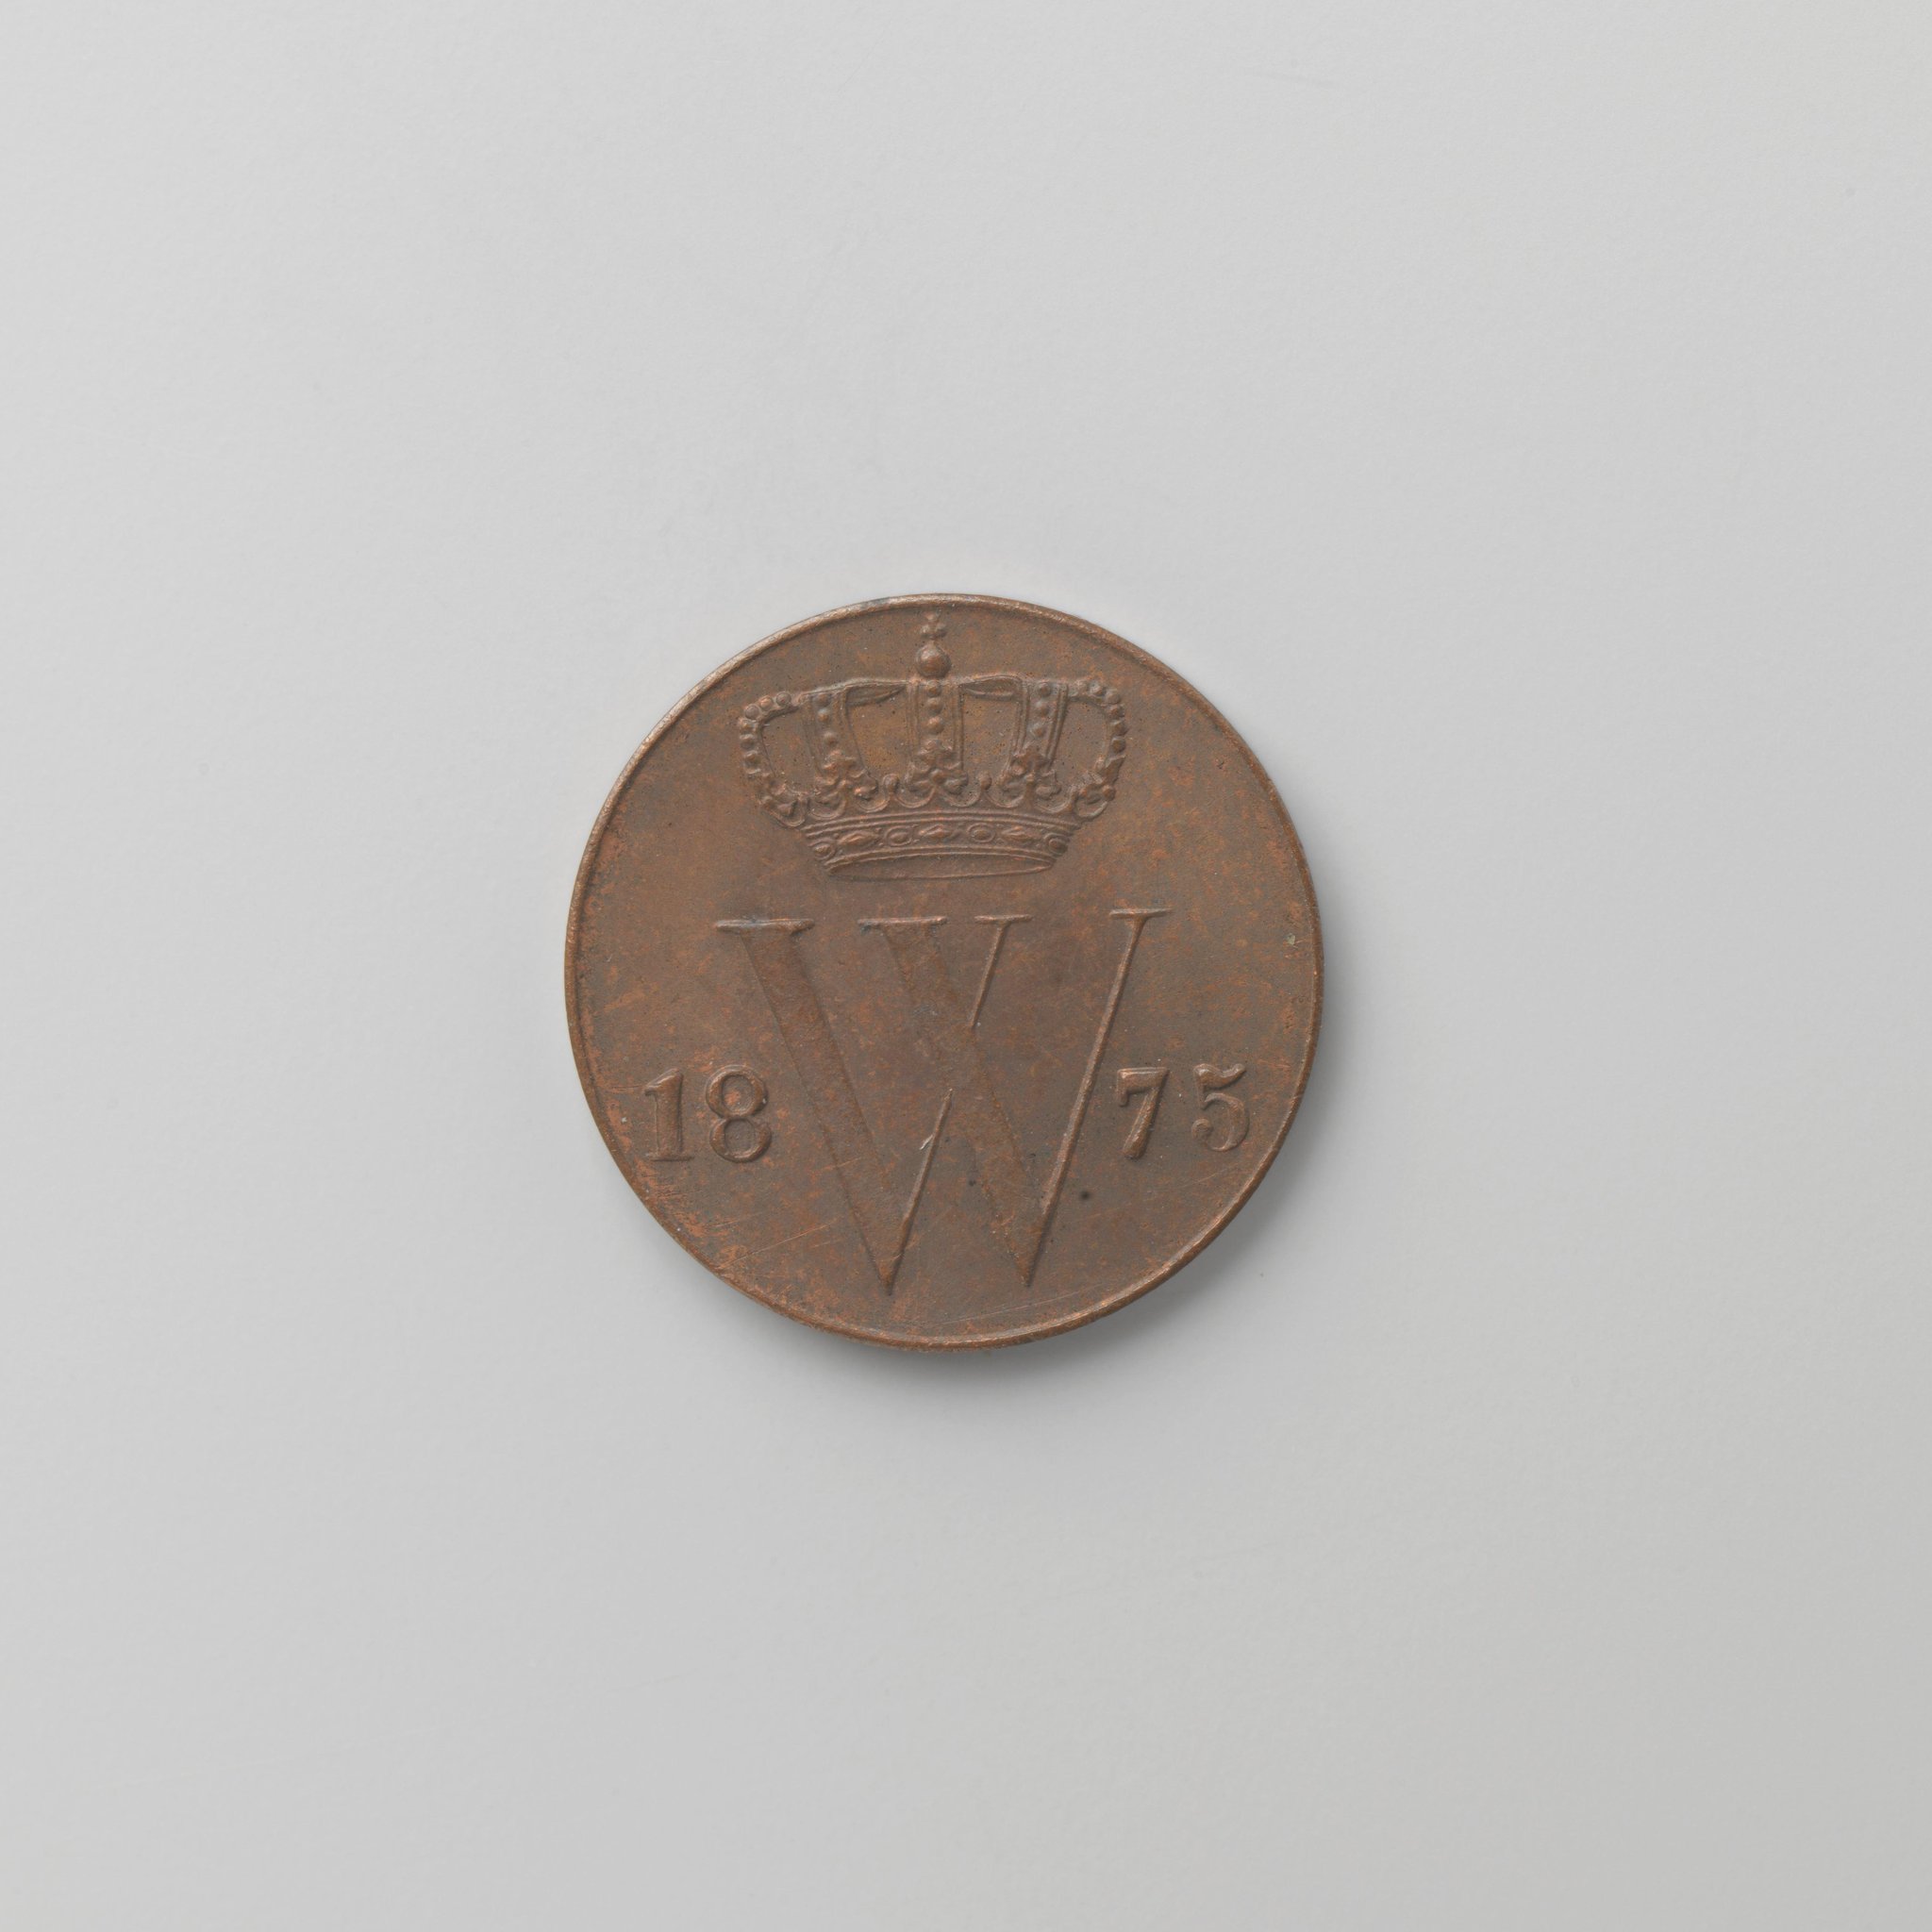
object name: coin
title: Nederland, ½ cent, 1875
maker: willem iii (koning der nederlanden)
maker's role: koning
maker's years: 1817-1890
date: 1875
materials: copper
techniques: striking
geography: utrecht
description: Koperen munt. Voorzijde: tussen jaartal gekroonde rechte letter W. Keerzijde: tussen waarde-aanduiding ½ C. gekroond rijkswapenschild. Gladde rand.